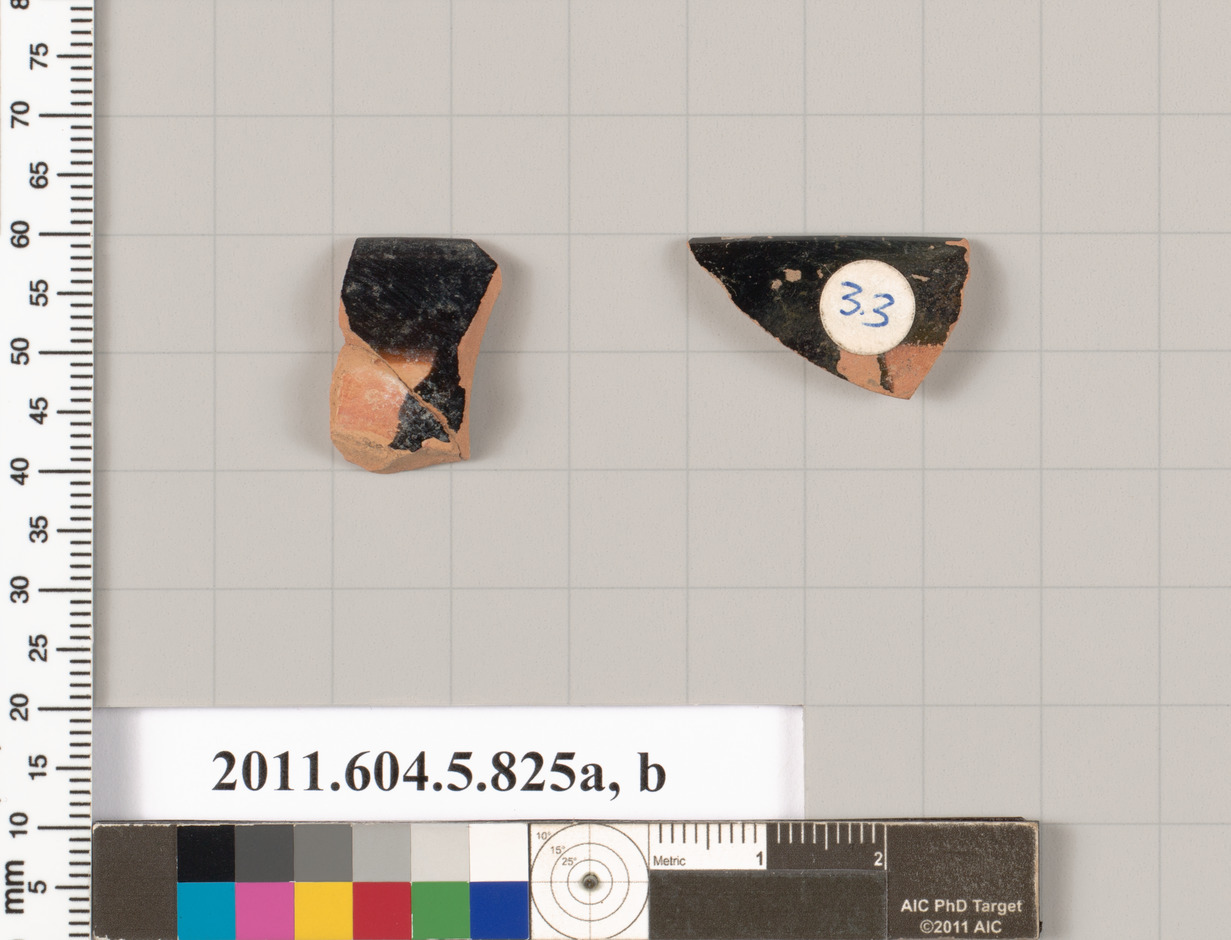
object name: kylix fragment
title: Terracotta rim fragments of kylikes (drinking cups)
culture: greek, attic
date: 600-401 BCE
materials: terracotta